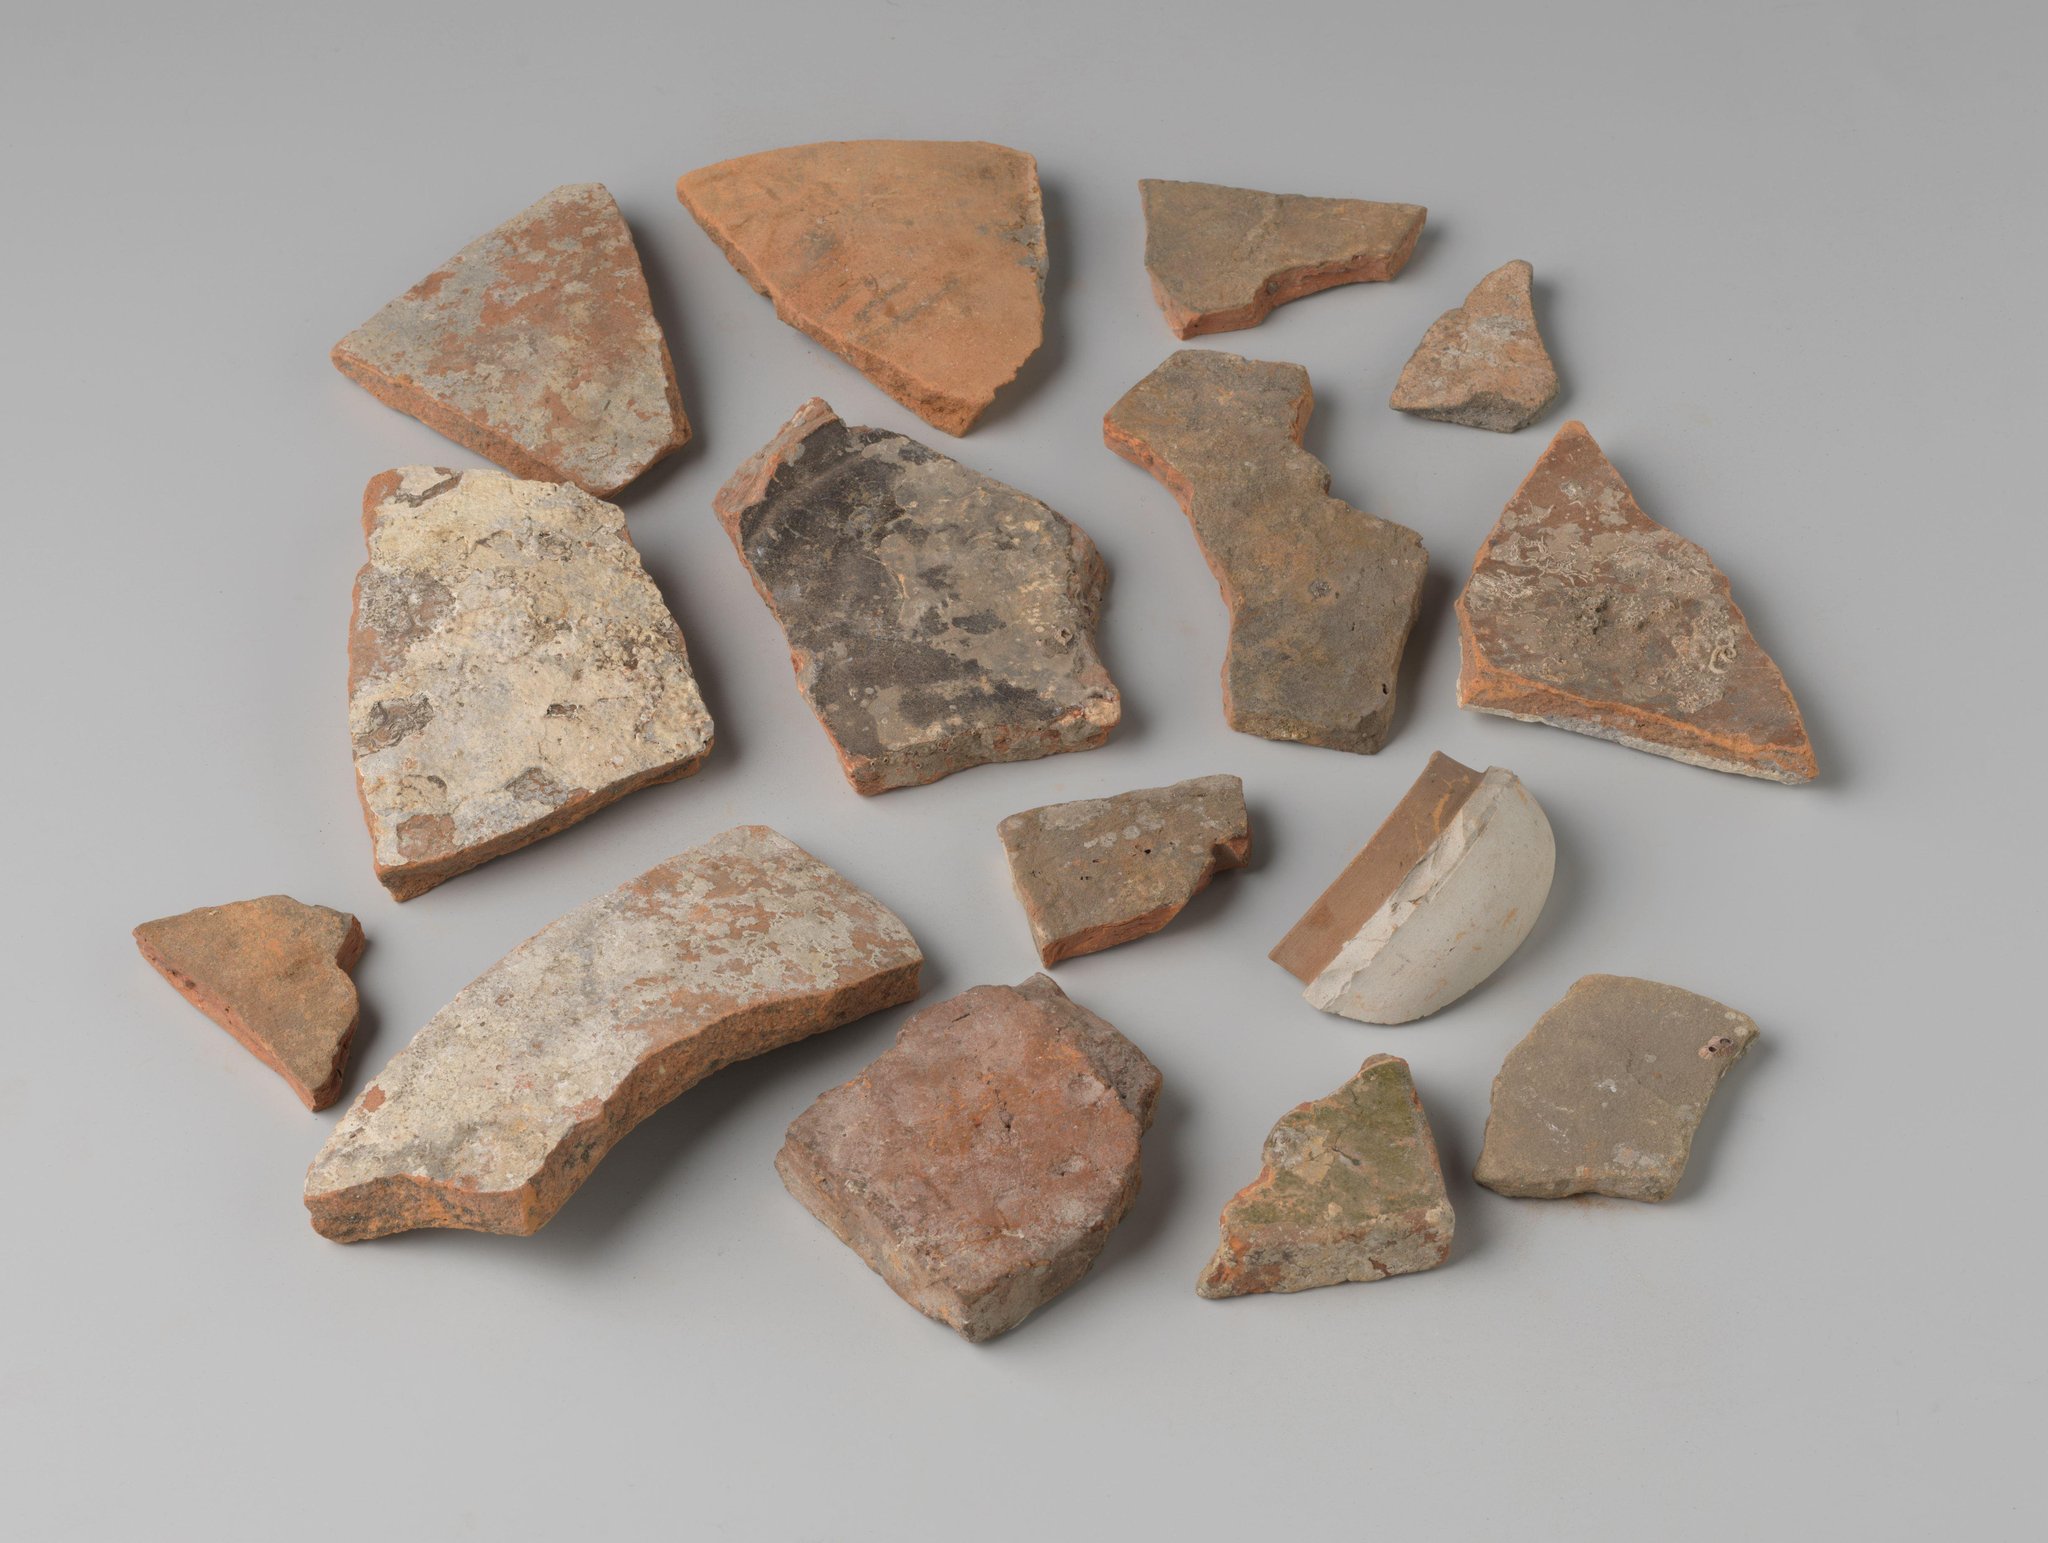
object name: sherd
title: Scherven aardewerk en steengoed uit V.O.C.-schip de 'Witte Leeuw'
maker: Anonymous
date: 1613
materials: earthenware, glaze, stoneware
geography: western europe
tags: verenigde oostindische compagnie, sint-helena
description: Scherven aardewerk en steengoed van onder andere kombuistegels uit V.O.C.-schip de 'Witte Leeuw'.